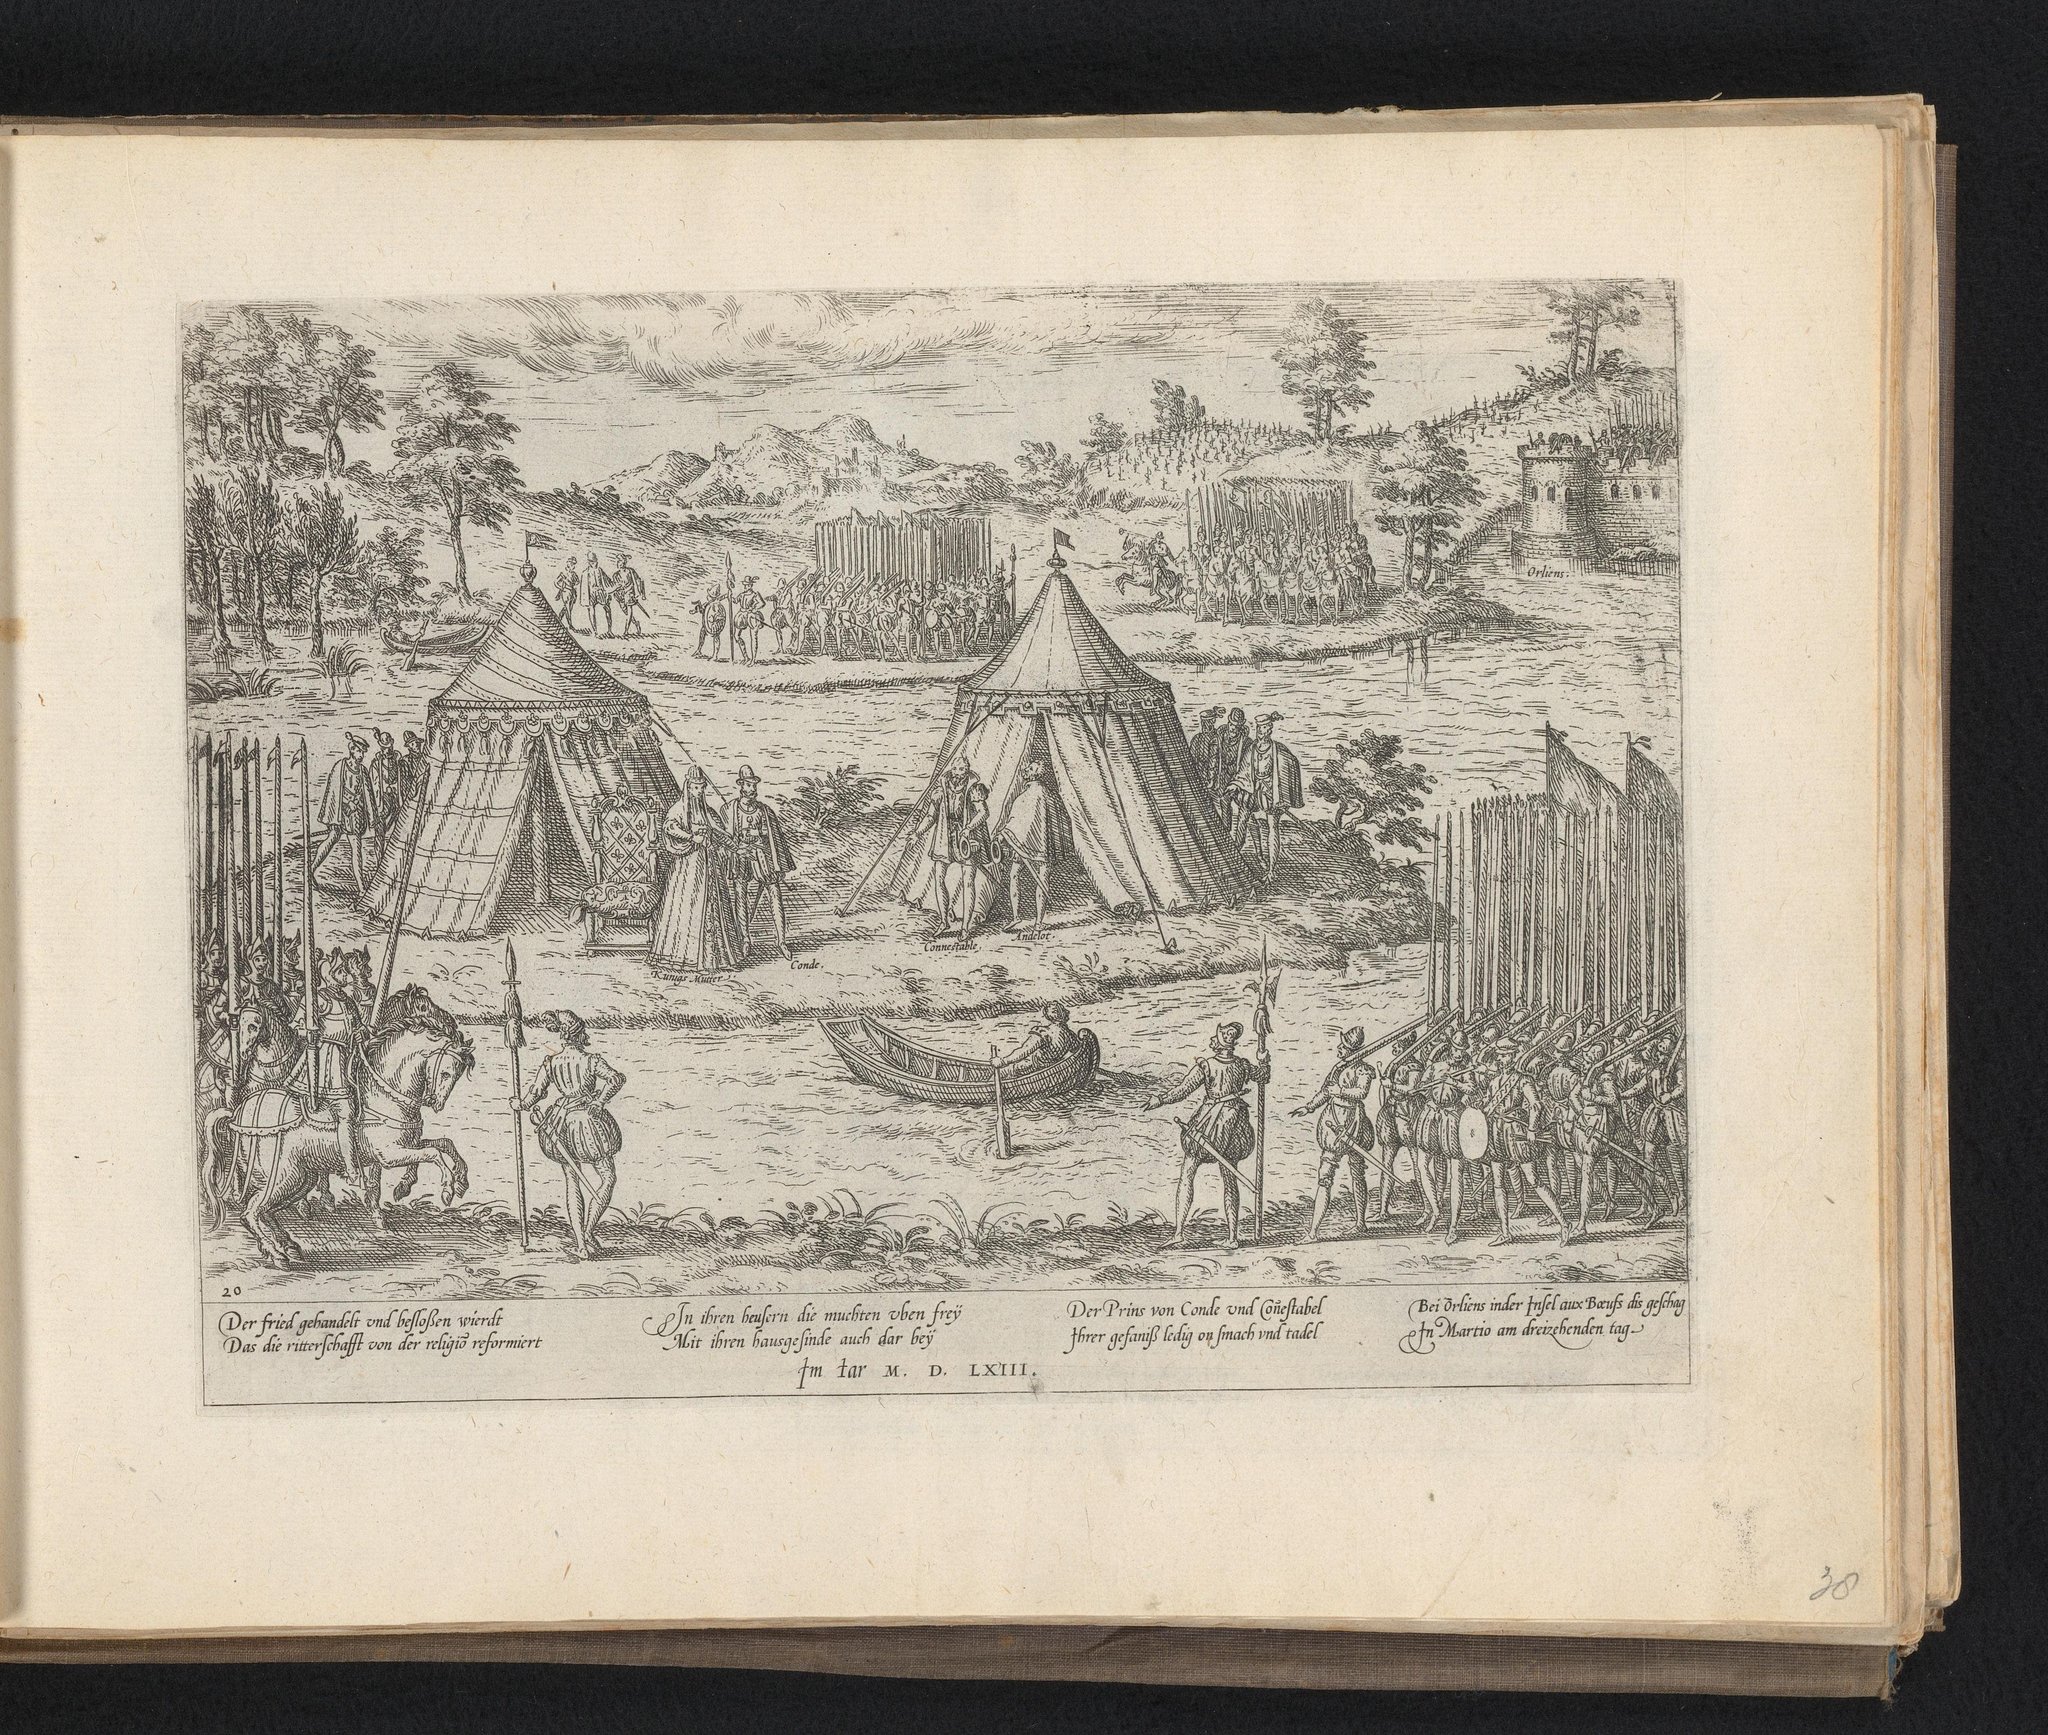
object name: print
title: Vrede bij Orléans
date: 1563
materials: paper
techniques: etching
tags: militant proselytizing: religious war, crusade, etc., signing of peace treaty, concluding the peace, the roman catholic church vs. protestantism; (reformation and counter reformation)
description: Prent gebruikt in: Aitsinger, Michael. De Leone Belgico (...). Keulen: s.n., 1588.